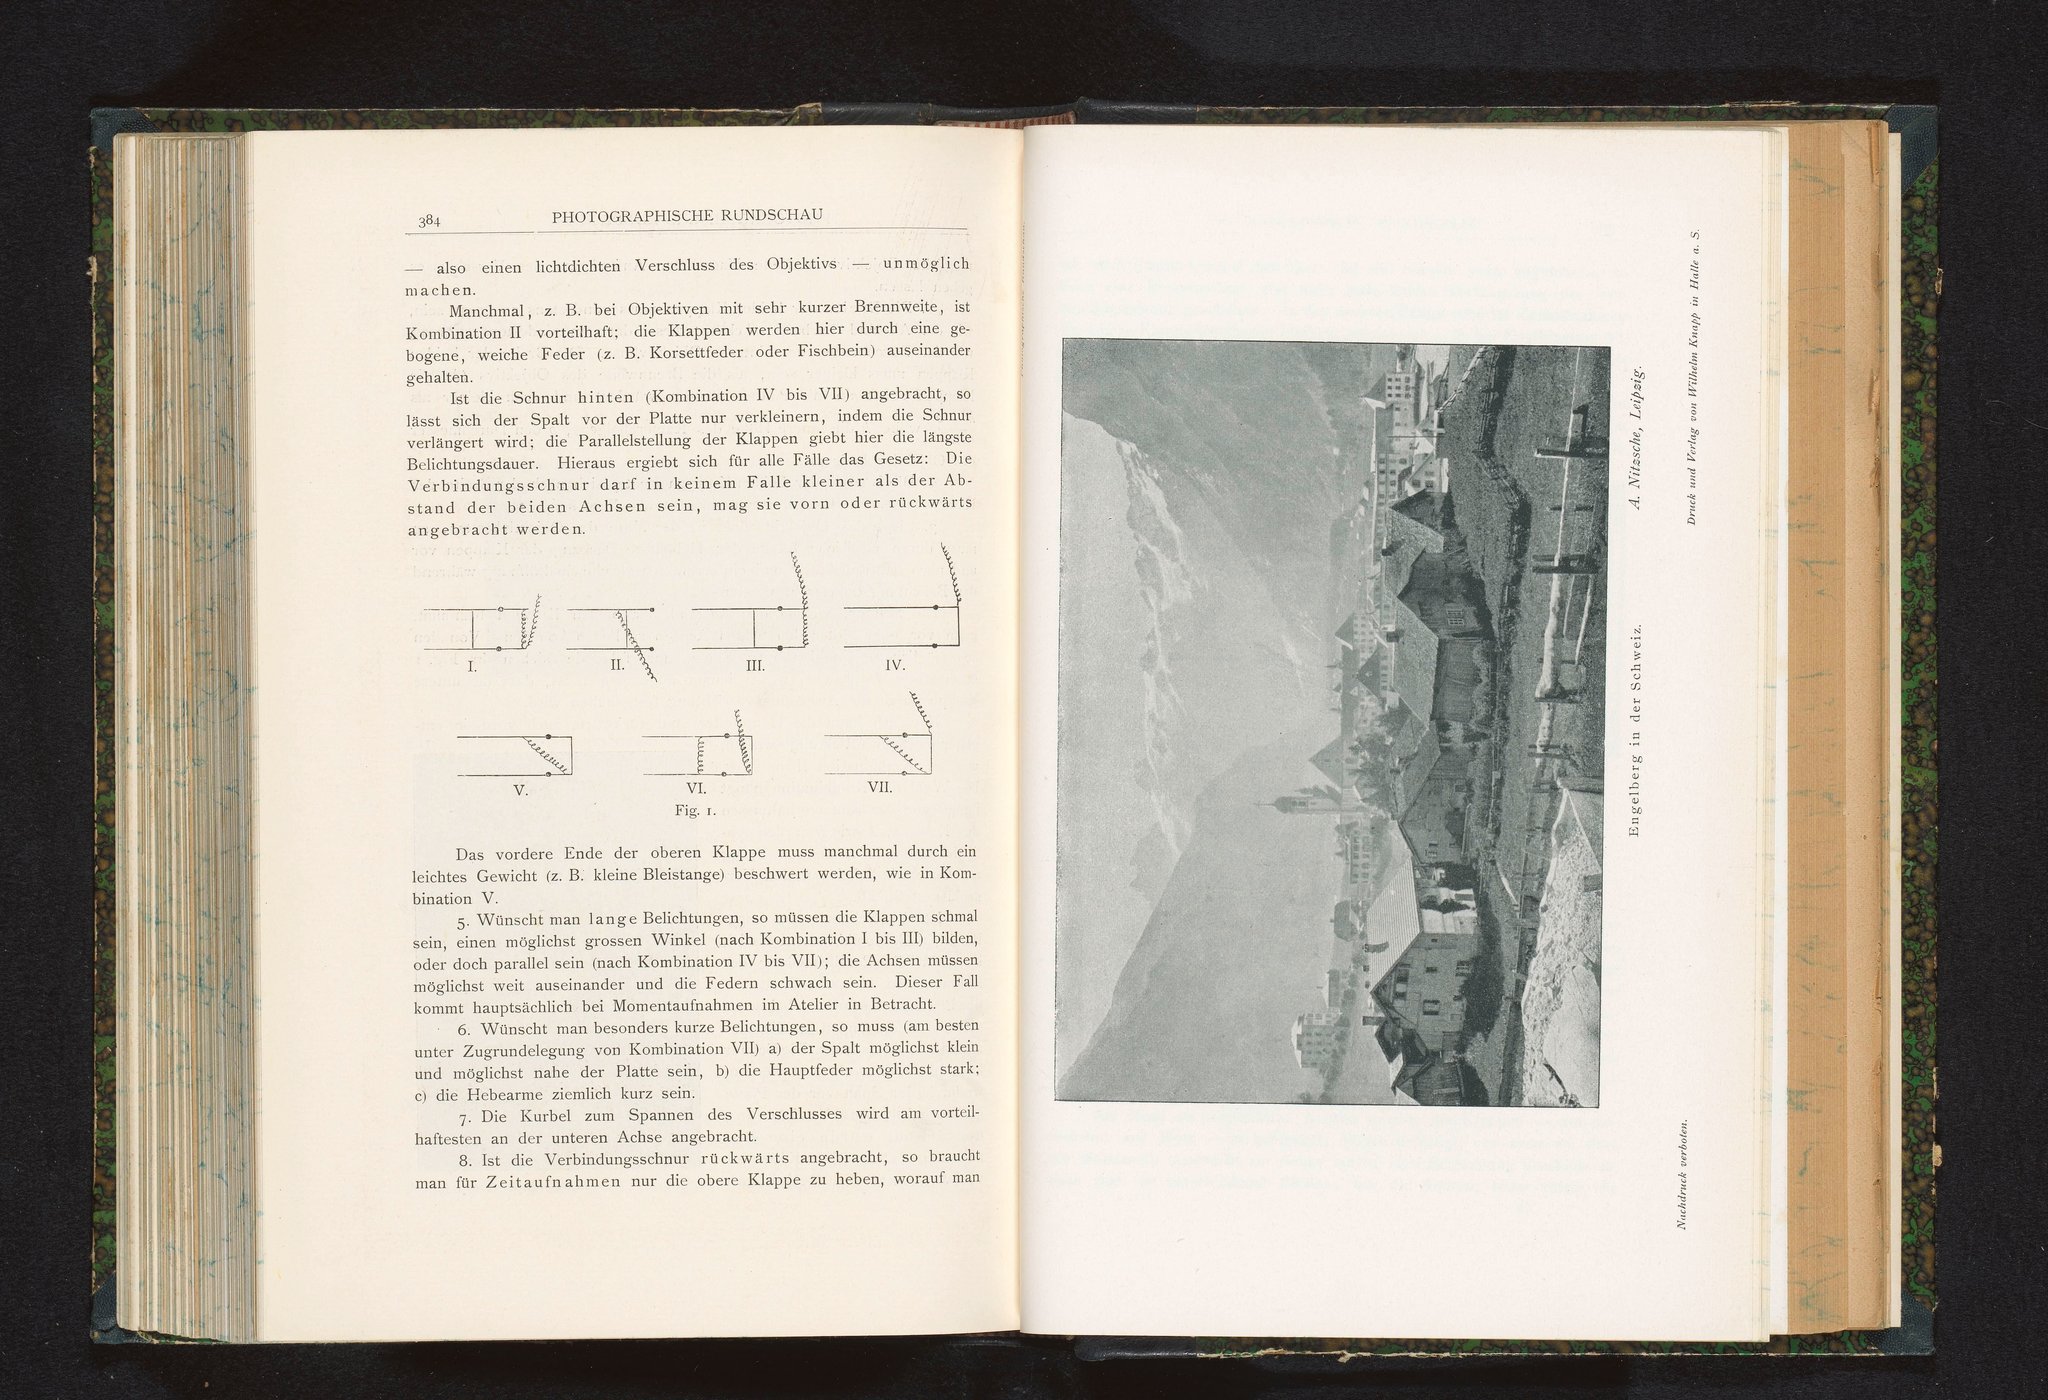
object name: photomechanical print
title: Gezicht op Engelberg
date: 1894-1899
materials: paper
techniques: autotype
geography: engelberg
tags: city-view, and landscape with man-made constructions, mountains